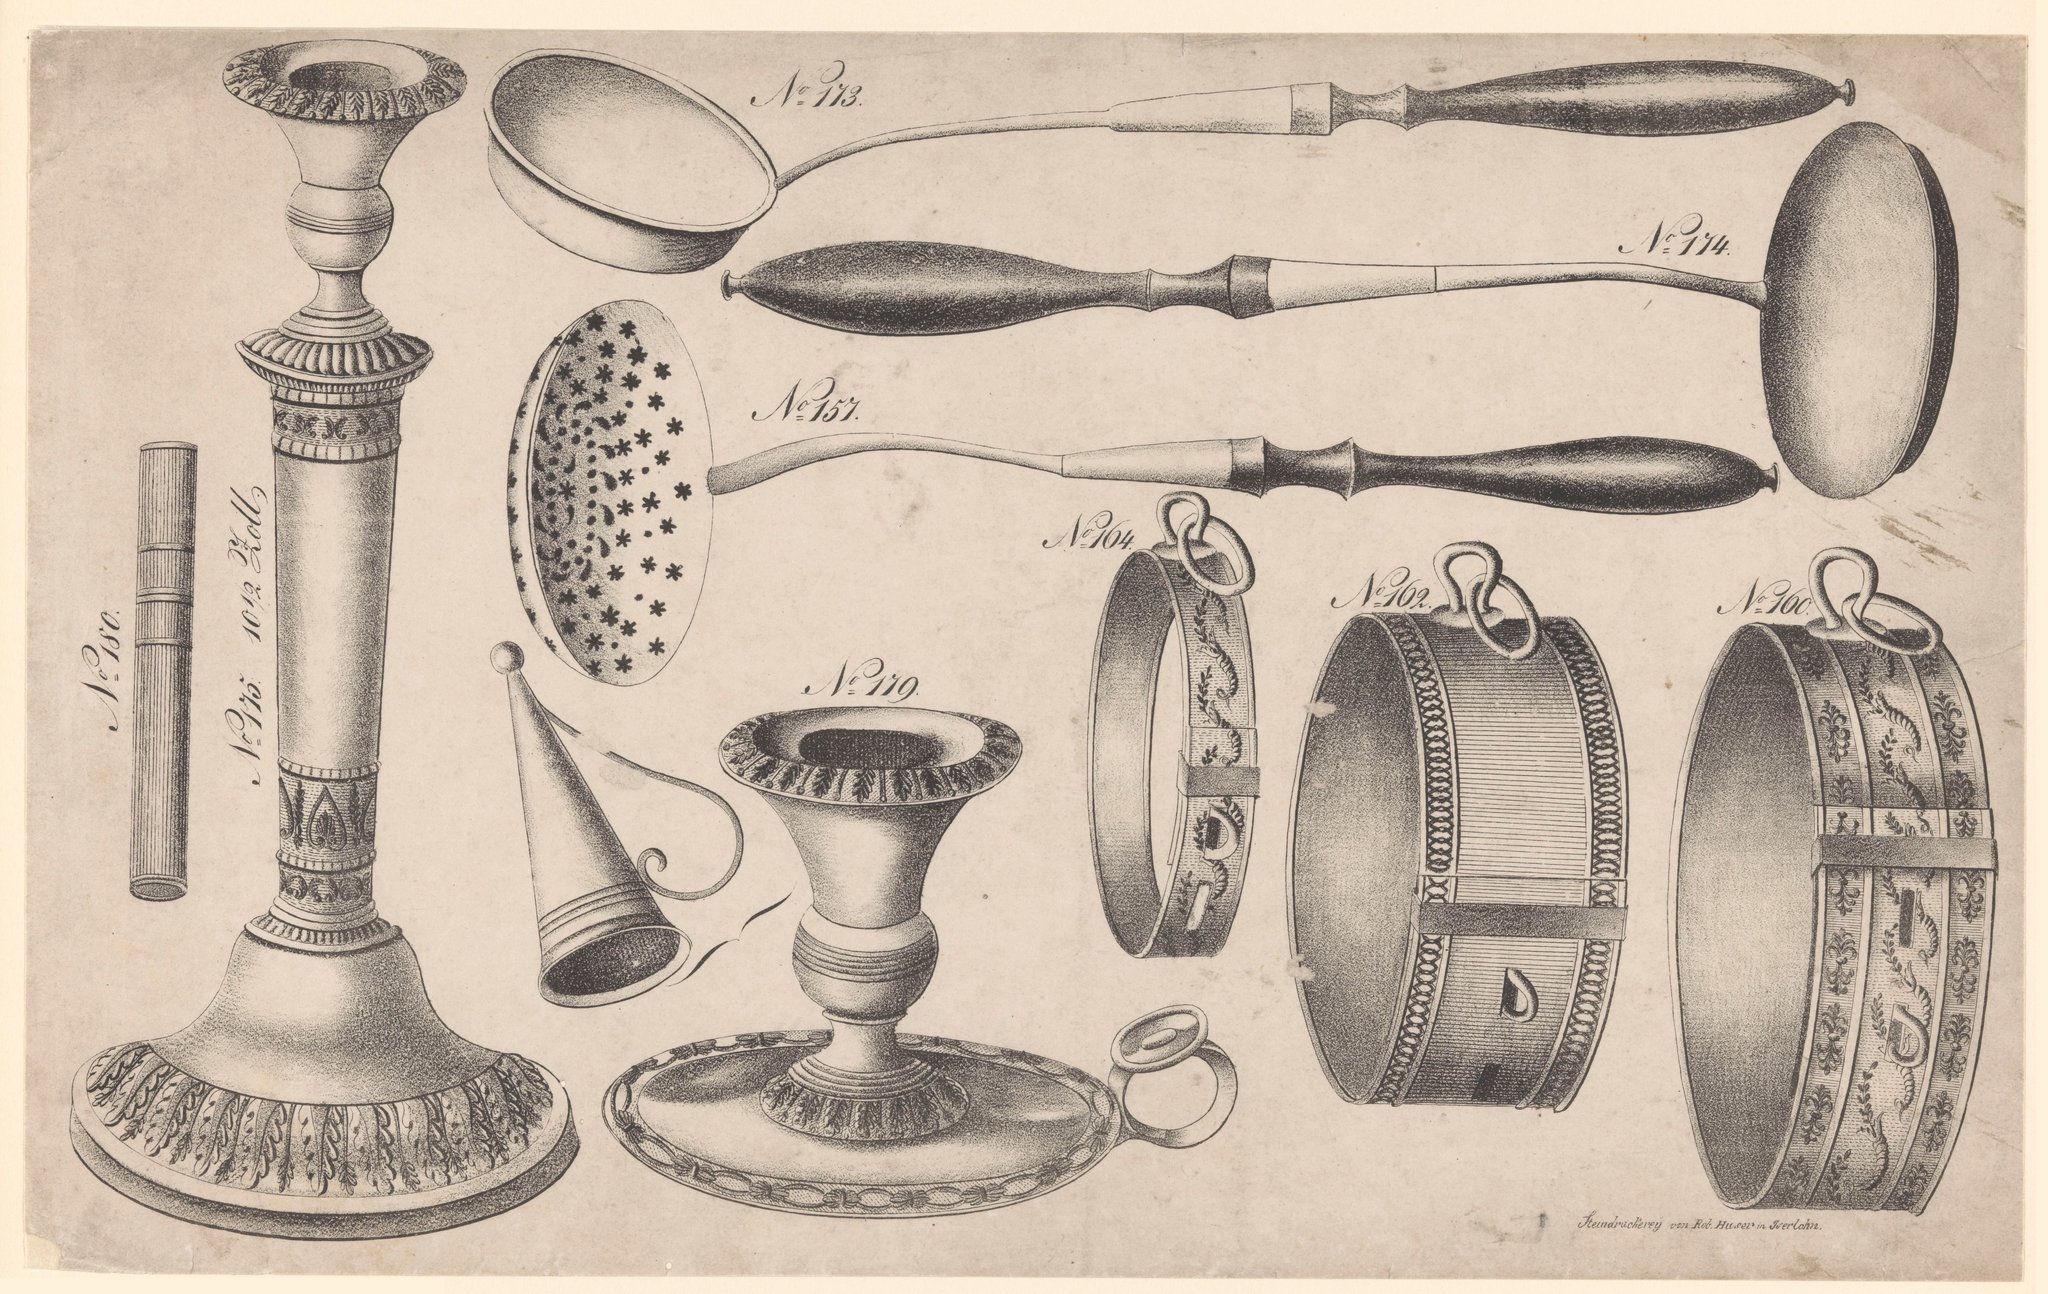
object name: ornament print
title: Empirevoorwerpen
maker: Anonymous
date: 1820-1840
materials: paper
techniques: lithograph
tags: snuffers, chandelier, candelabrum, styles in the fine arts (+ later developments), spoon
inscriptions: collector's mark: Lugt 2228, collector's mark: Lugt 2760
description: Waarschijnlijk onderdeel van een catalogus. Mogelijke prentmaker of drukker is Firma Leudesdorf-Mansfeld te Elberfeld. Zie RP-P-1965-504 en 505.